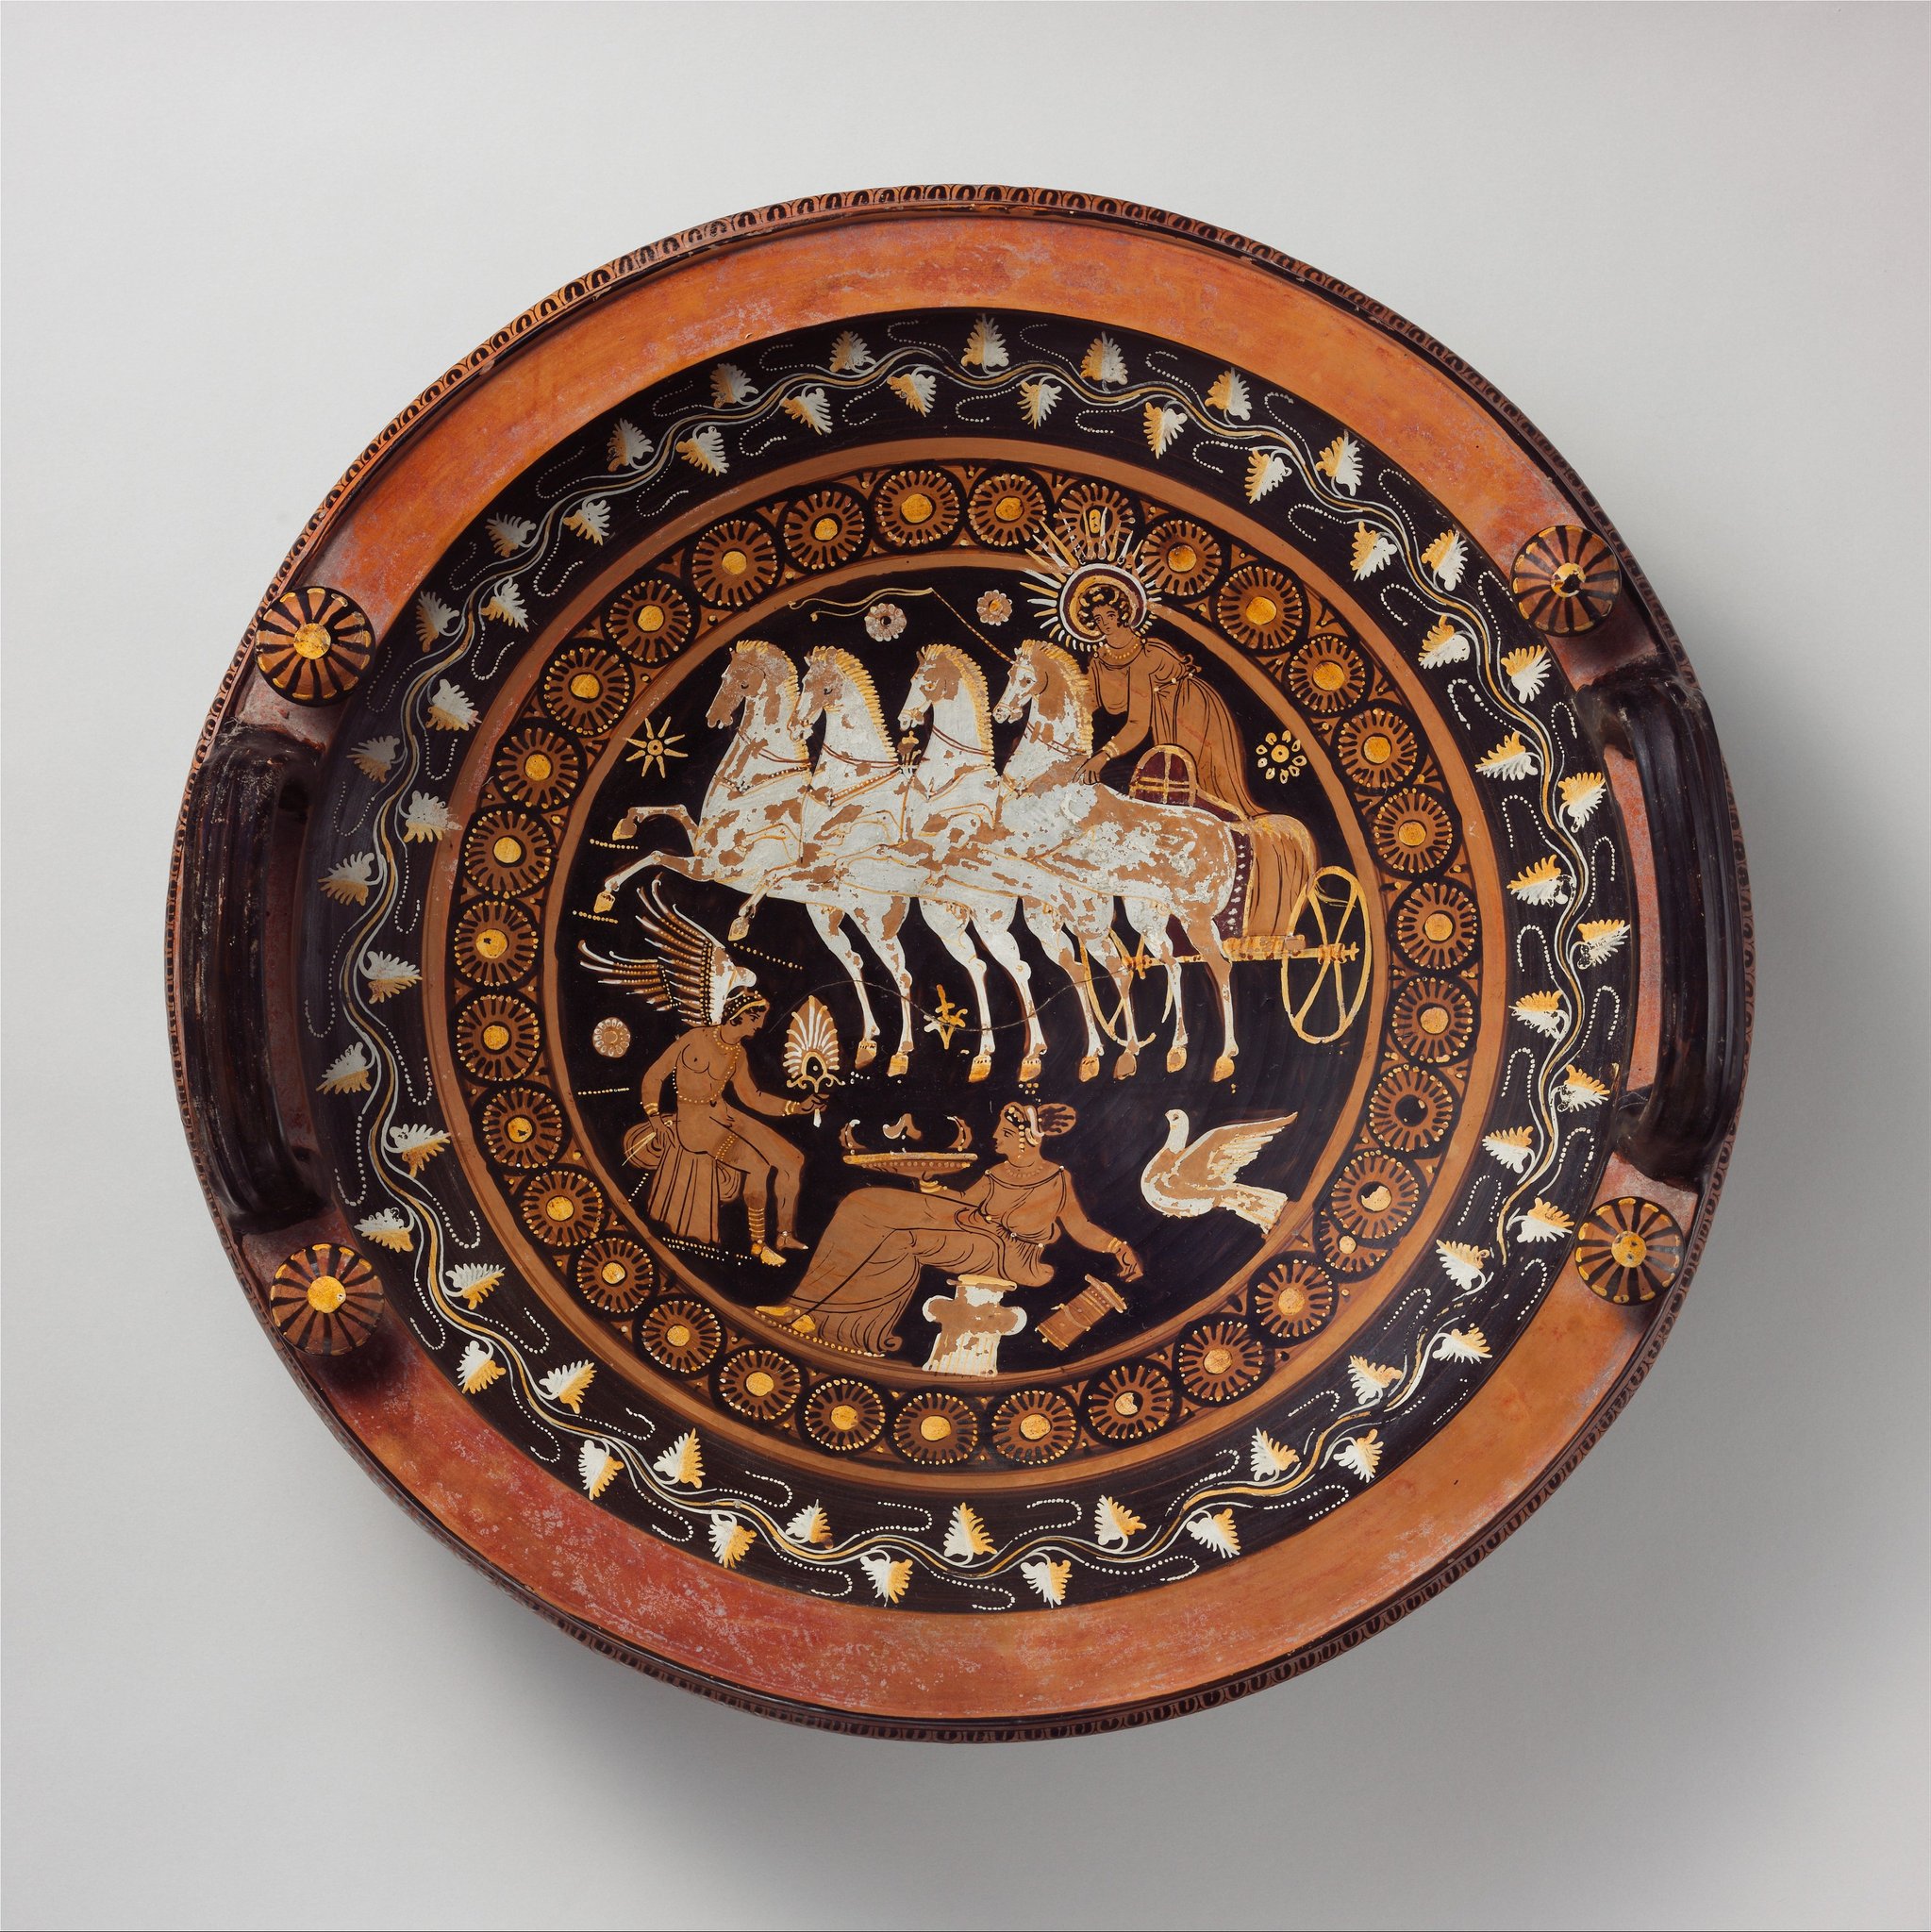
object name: lekanis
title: Terracotta lekanis (dish)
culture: greek, south italian, apulian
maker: stuttgart group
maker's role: artist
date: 334-301 BCE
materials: terracotta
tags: birds,women,eros,horses,chariots